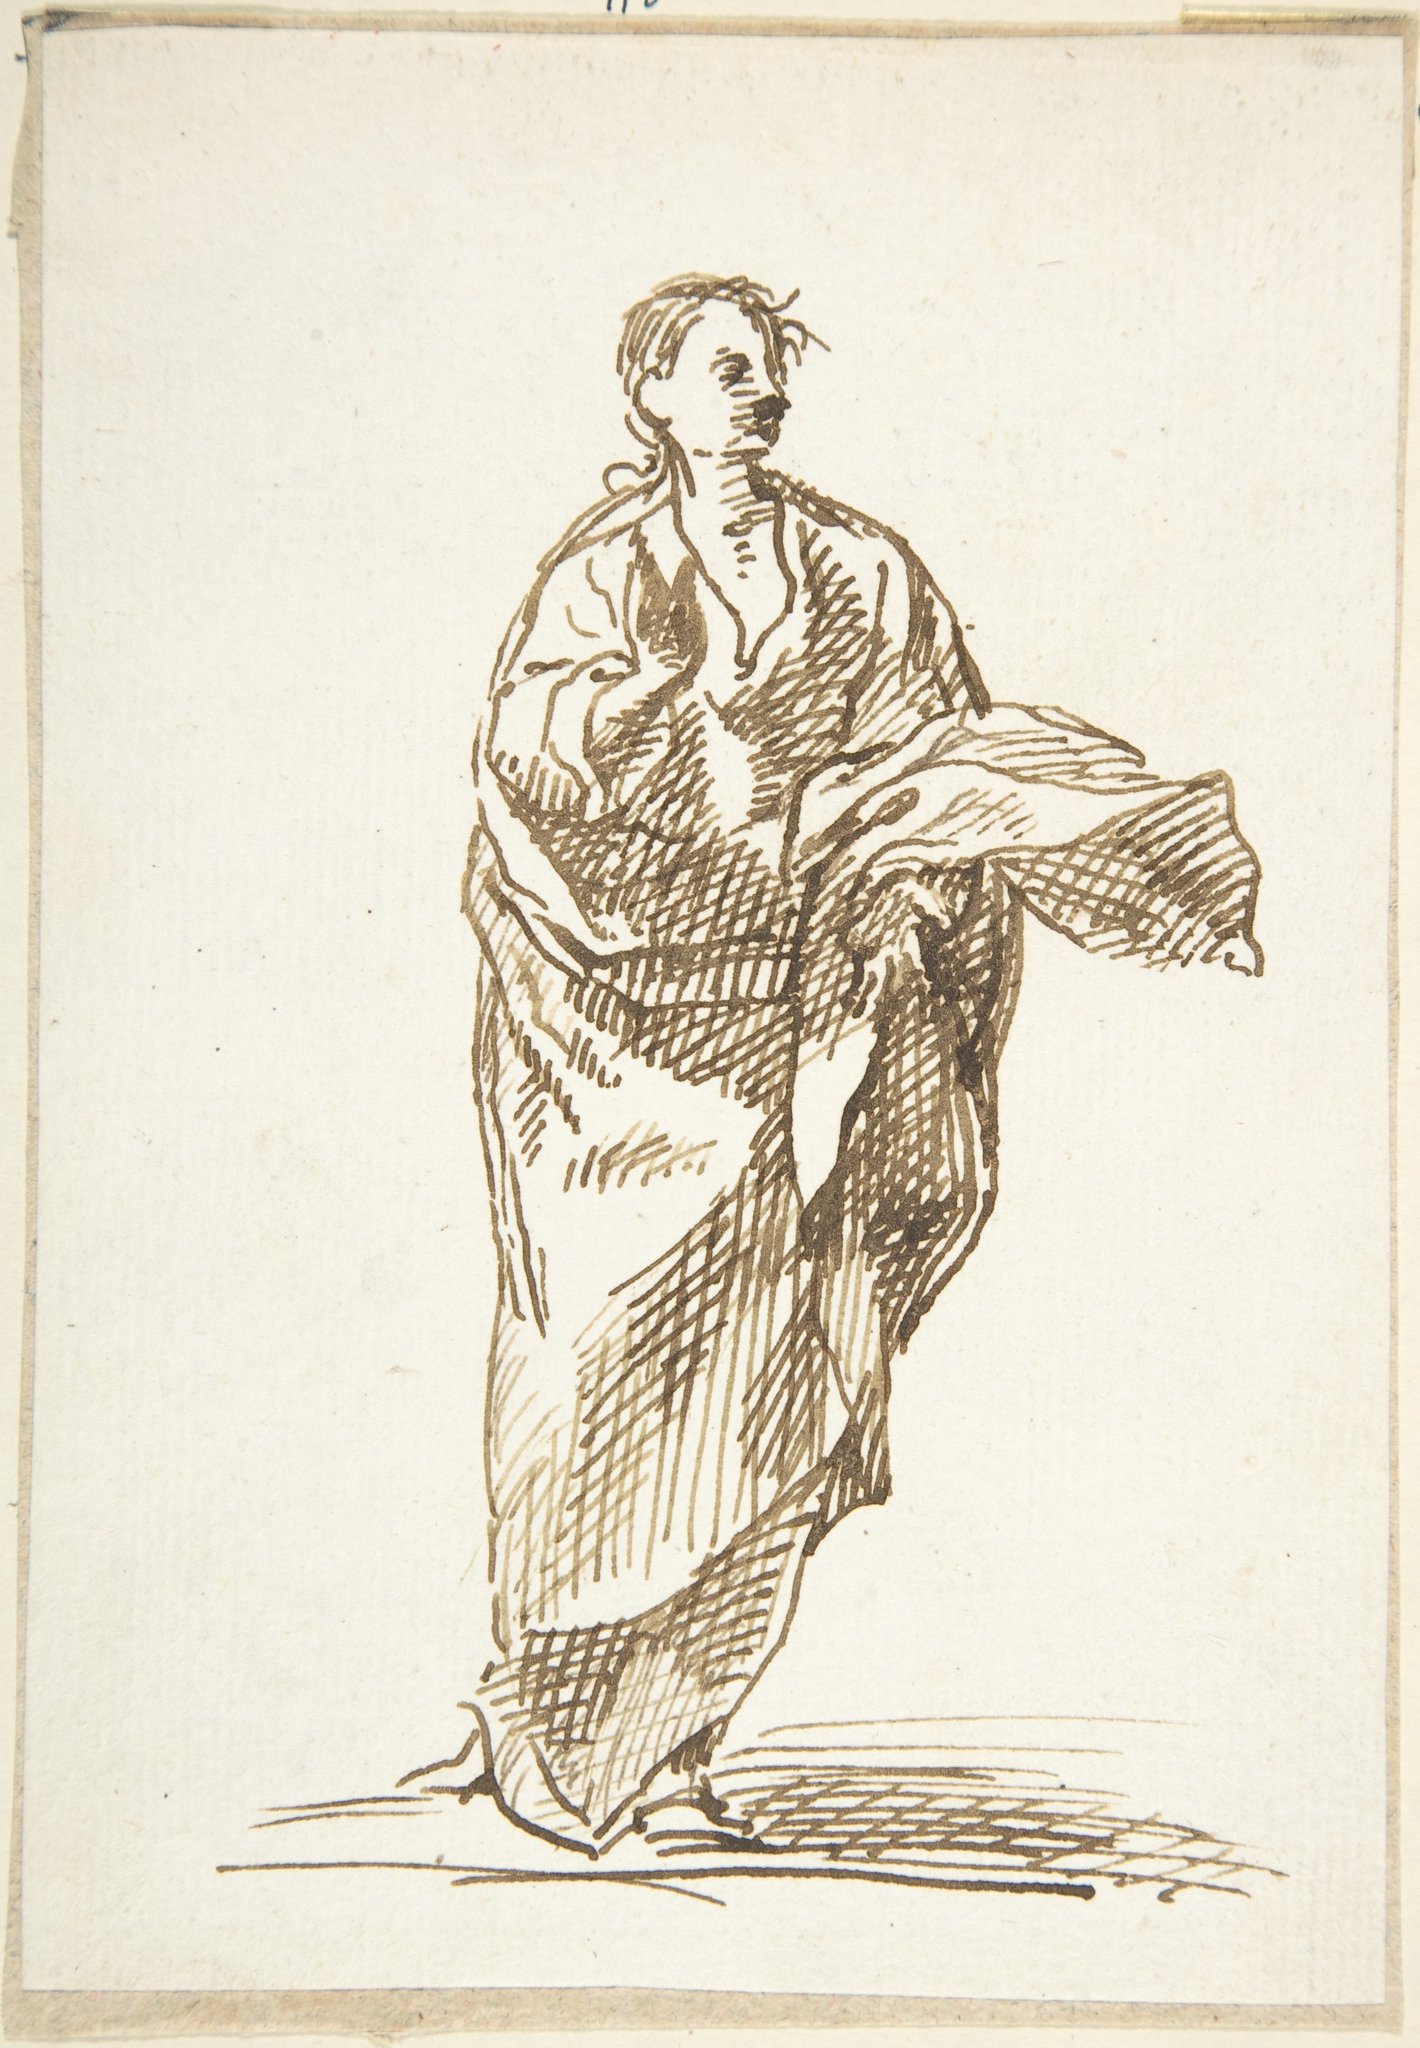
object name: drawing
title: Standing Male Saint (an Apostle?)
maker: pedro duque cornejo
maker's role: artist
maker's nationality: spanish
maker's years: 1677-1757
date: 1700-1750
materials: ink, ivory, paper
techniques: pen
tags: men